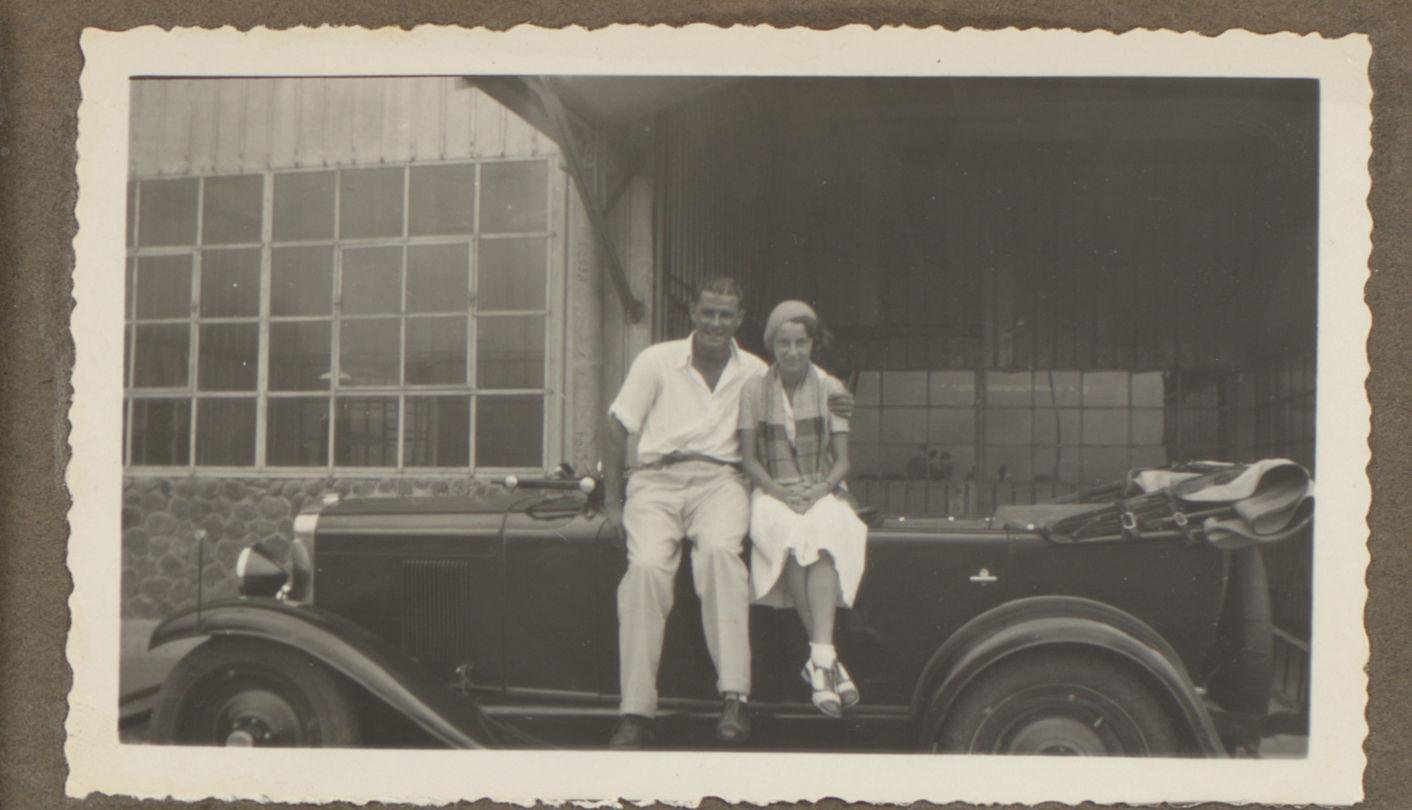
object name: album leaf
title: Portret van Edward Burch en Ada Krüseman op een auto, Tjibeber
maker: Anonymous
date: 1932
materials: paper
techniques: gelatin silver print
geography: tjibeber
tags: london, historical persons, automobile, couple of lovers